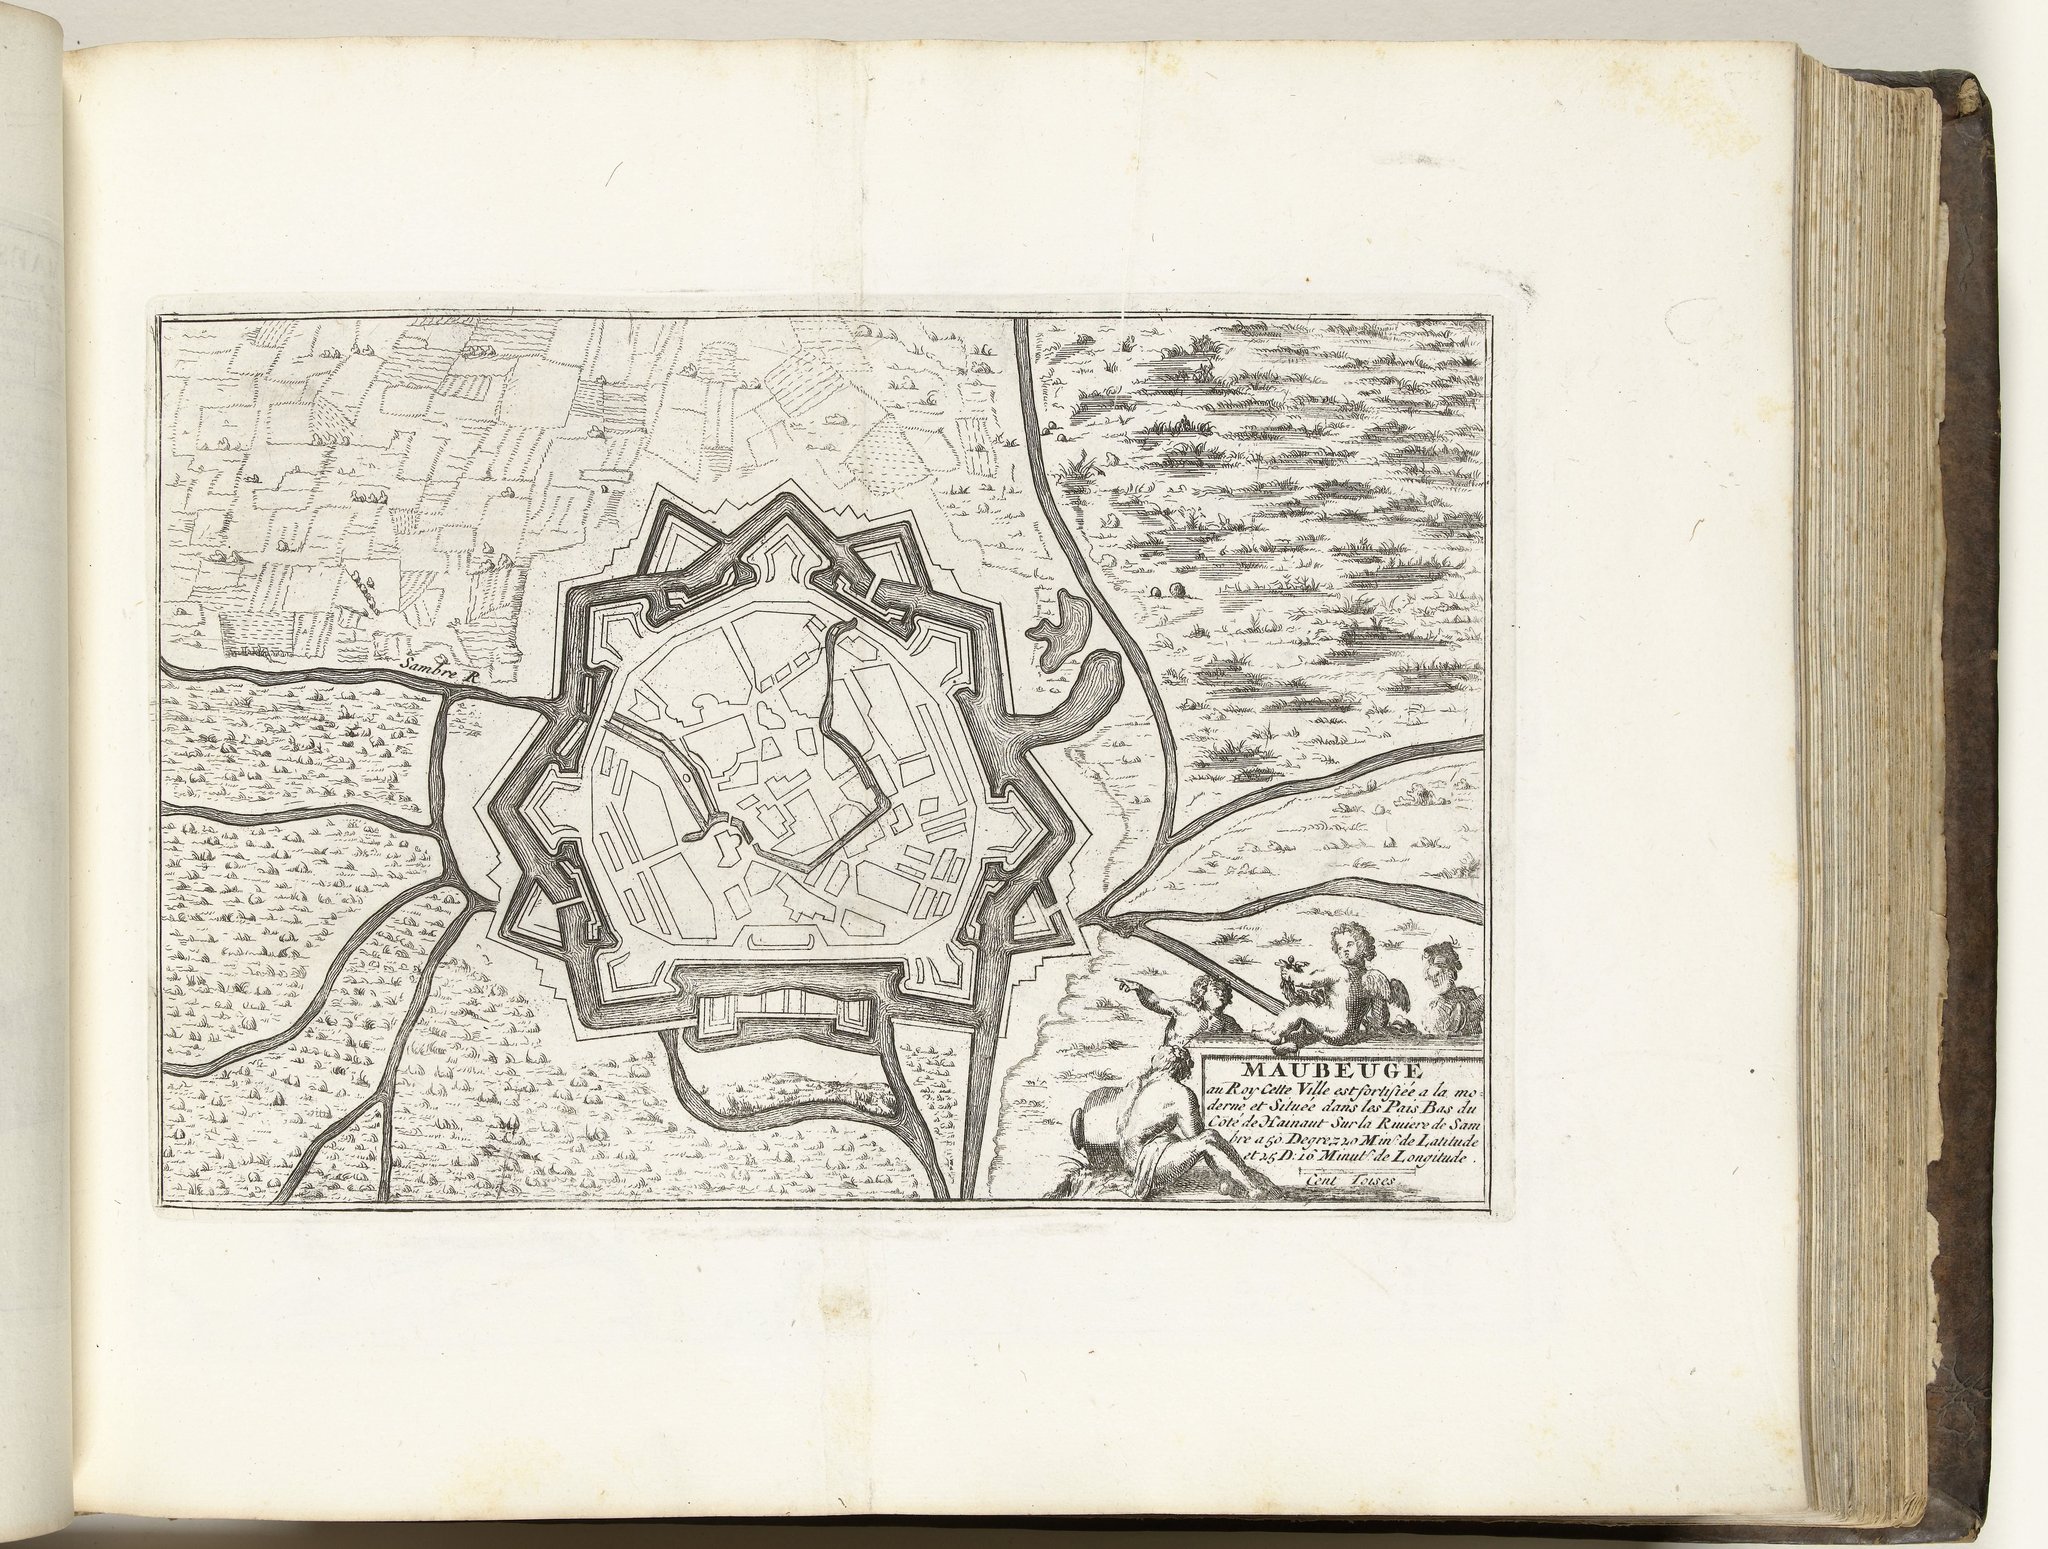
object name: print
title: Plattegrond van Maubeuge, ca. 1695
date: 1695-1697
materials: paper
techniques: etching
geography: paris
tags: fortress, maps of cities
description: Plattegrond van de versterkingen om de Franse stad Maubeuge. Onderdeel van het vierde deel (1697) van het prentwerk waarin gebundeld zijn de acht delen van Les forces de l'Europe uitgegeven tussen 1693-1697. Het prentwerk bestaat uit 175 platen met plannen (afkomstig van Sébastien Le Prestre, Seigneur de Vauban) van vermaarde sterke steden en vestingen in de Negenjarige Oorlog. Titel en opschriften in het Frans.